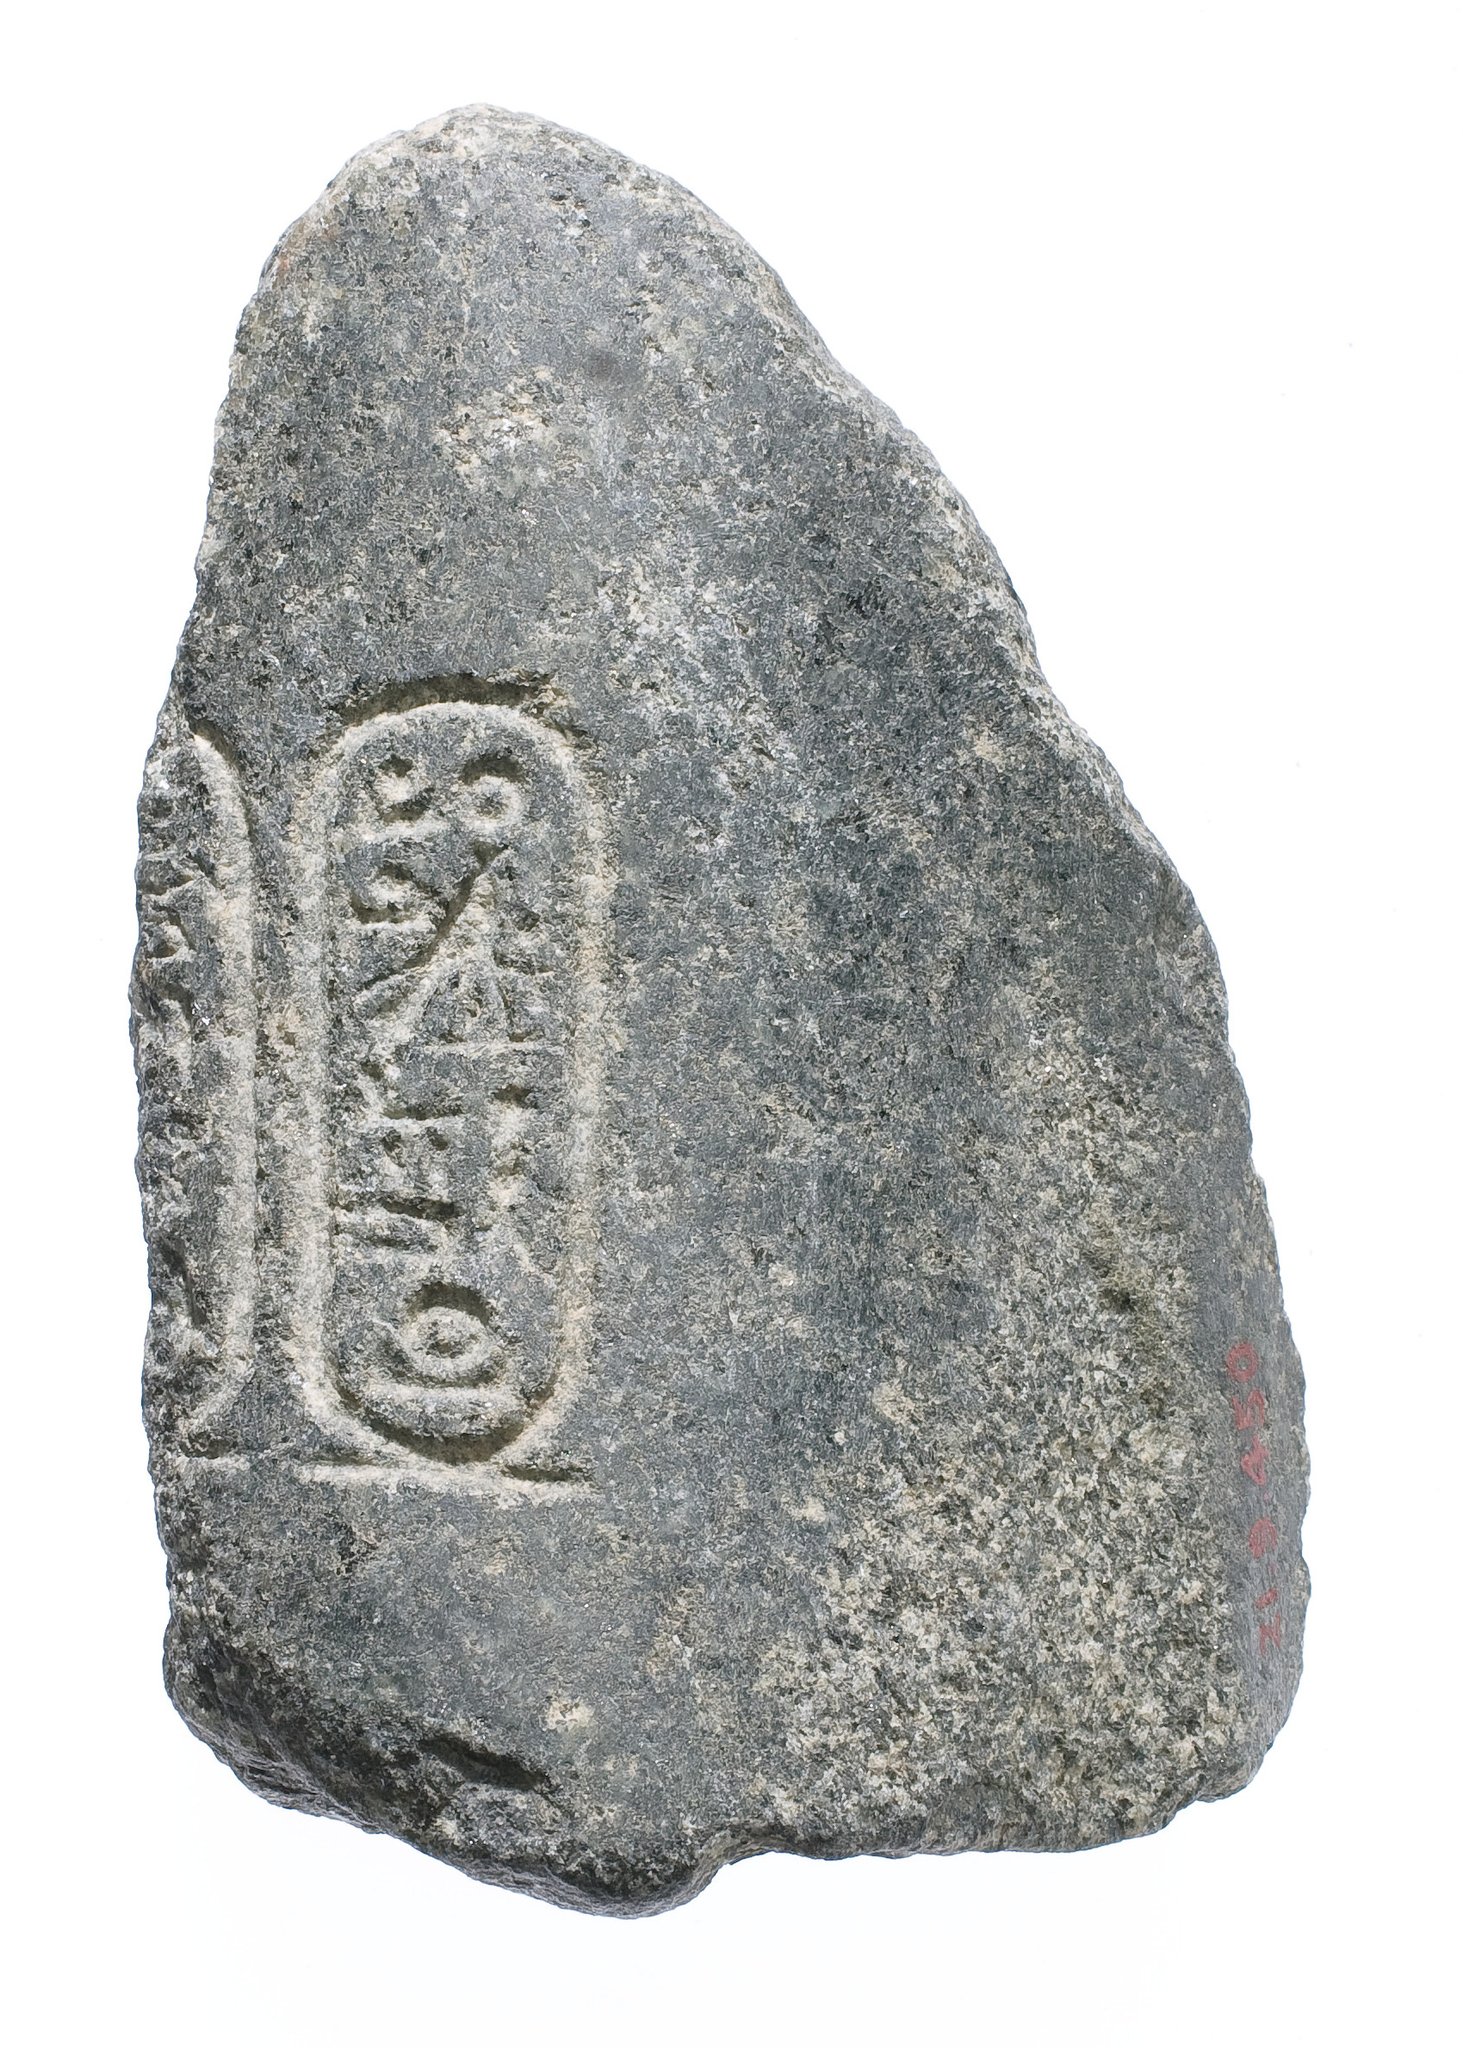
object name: upper right arm, aten cartouch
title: Upper right arm possibly with Aten cartouches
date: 1353-1336 BCE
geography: egypt